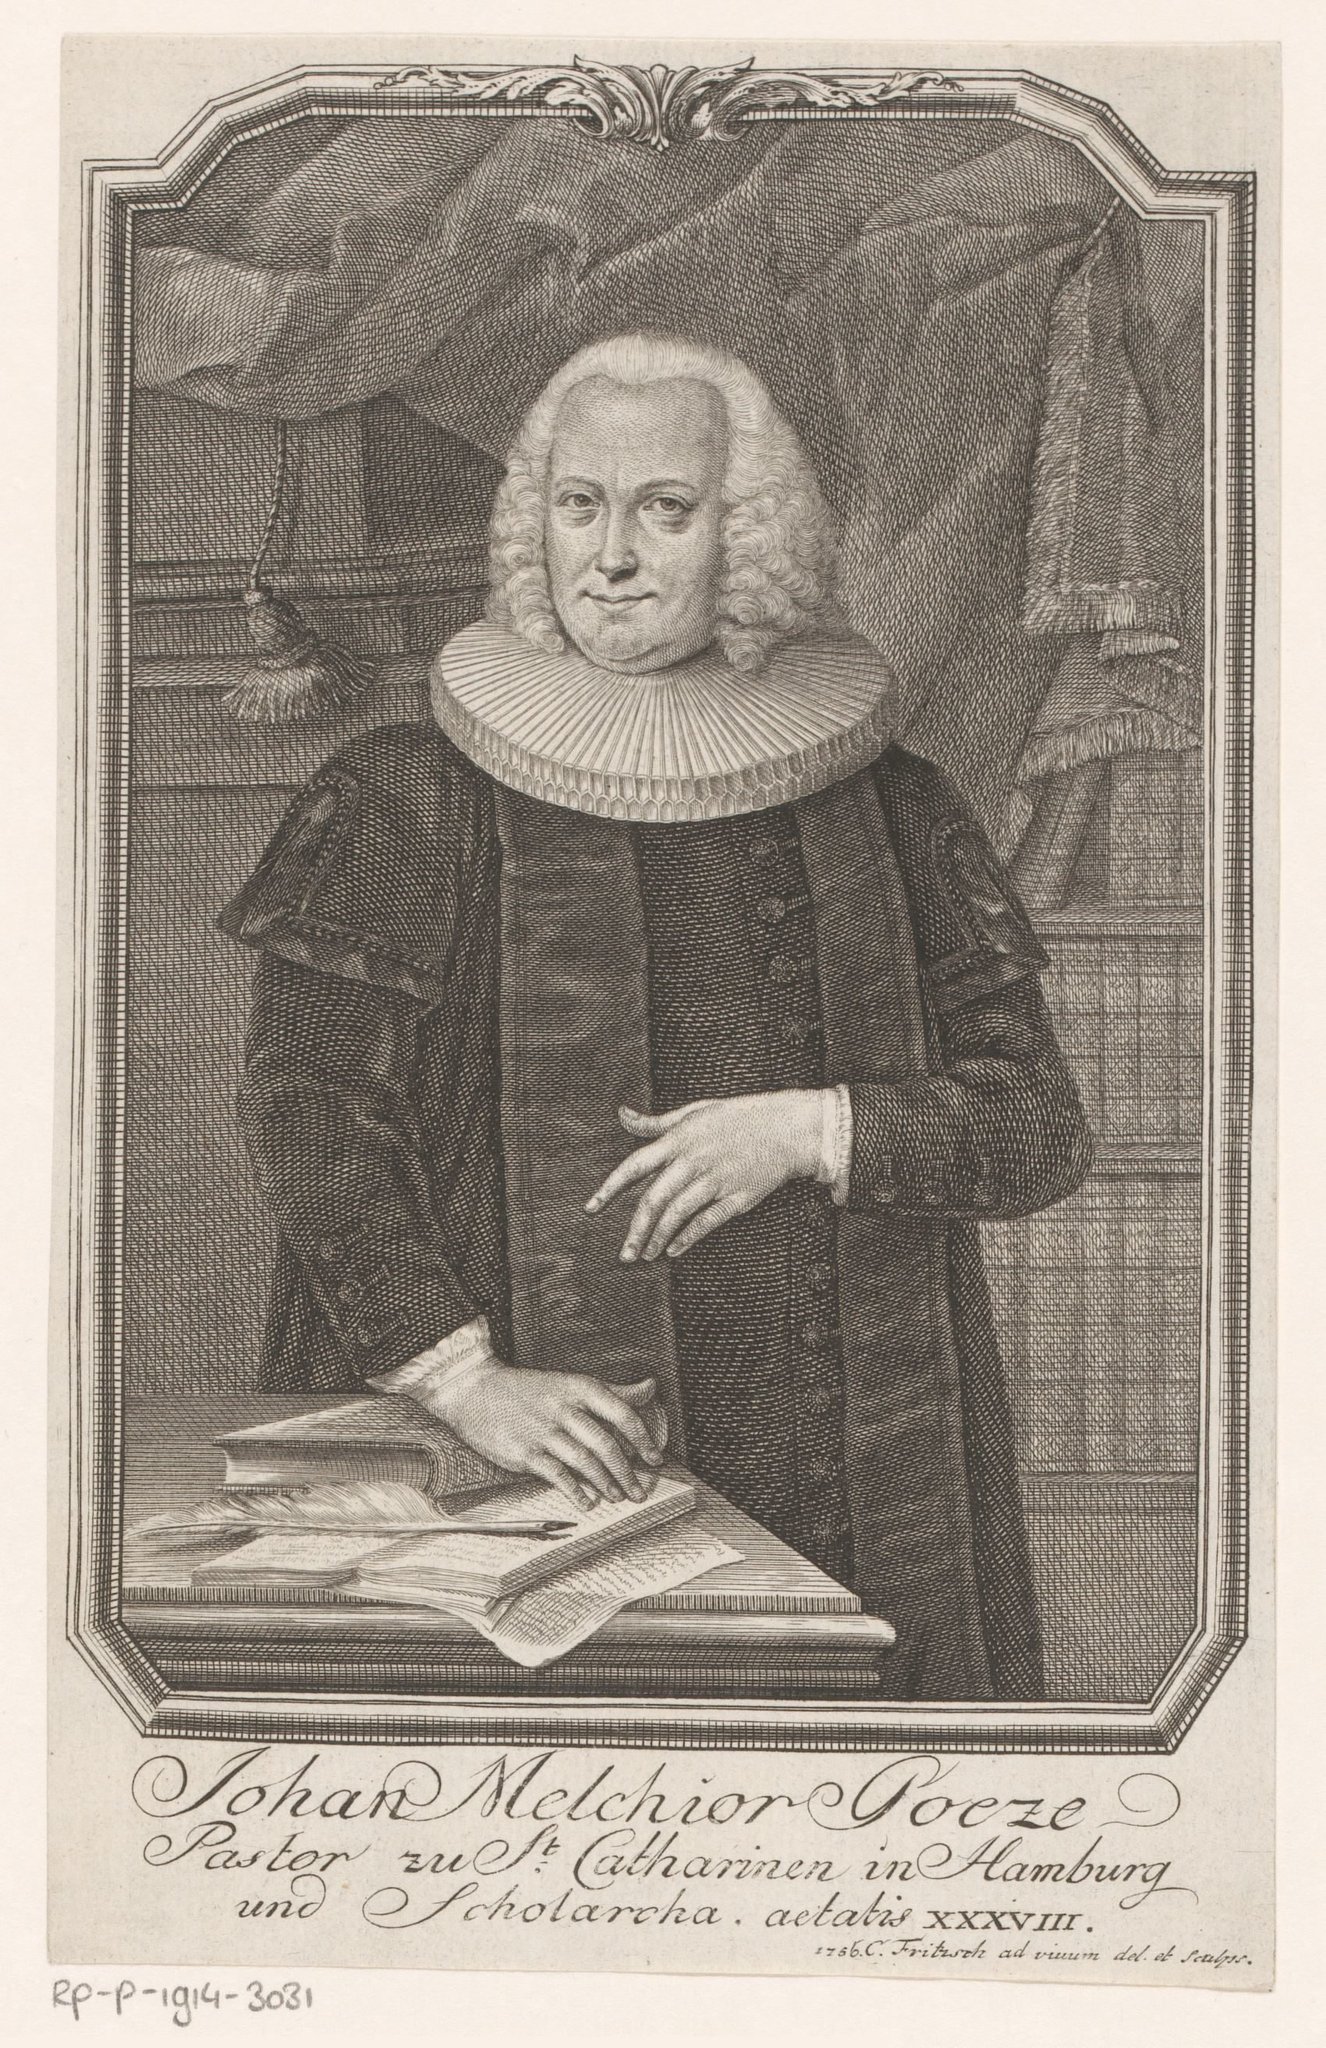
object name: print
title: Portret van Johan Melchior Goeze op 38-jarige leeftijd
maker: christian fritzsch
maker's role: print maker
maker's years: 1695-1769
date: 1756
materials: paper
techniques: engraving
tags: bookshelves, writing tools, historical persons, book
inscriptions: collector's mark: Lugt 2228